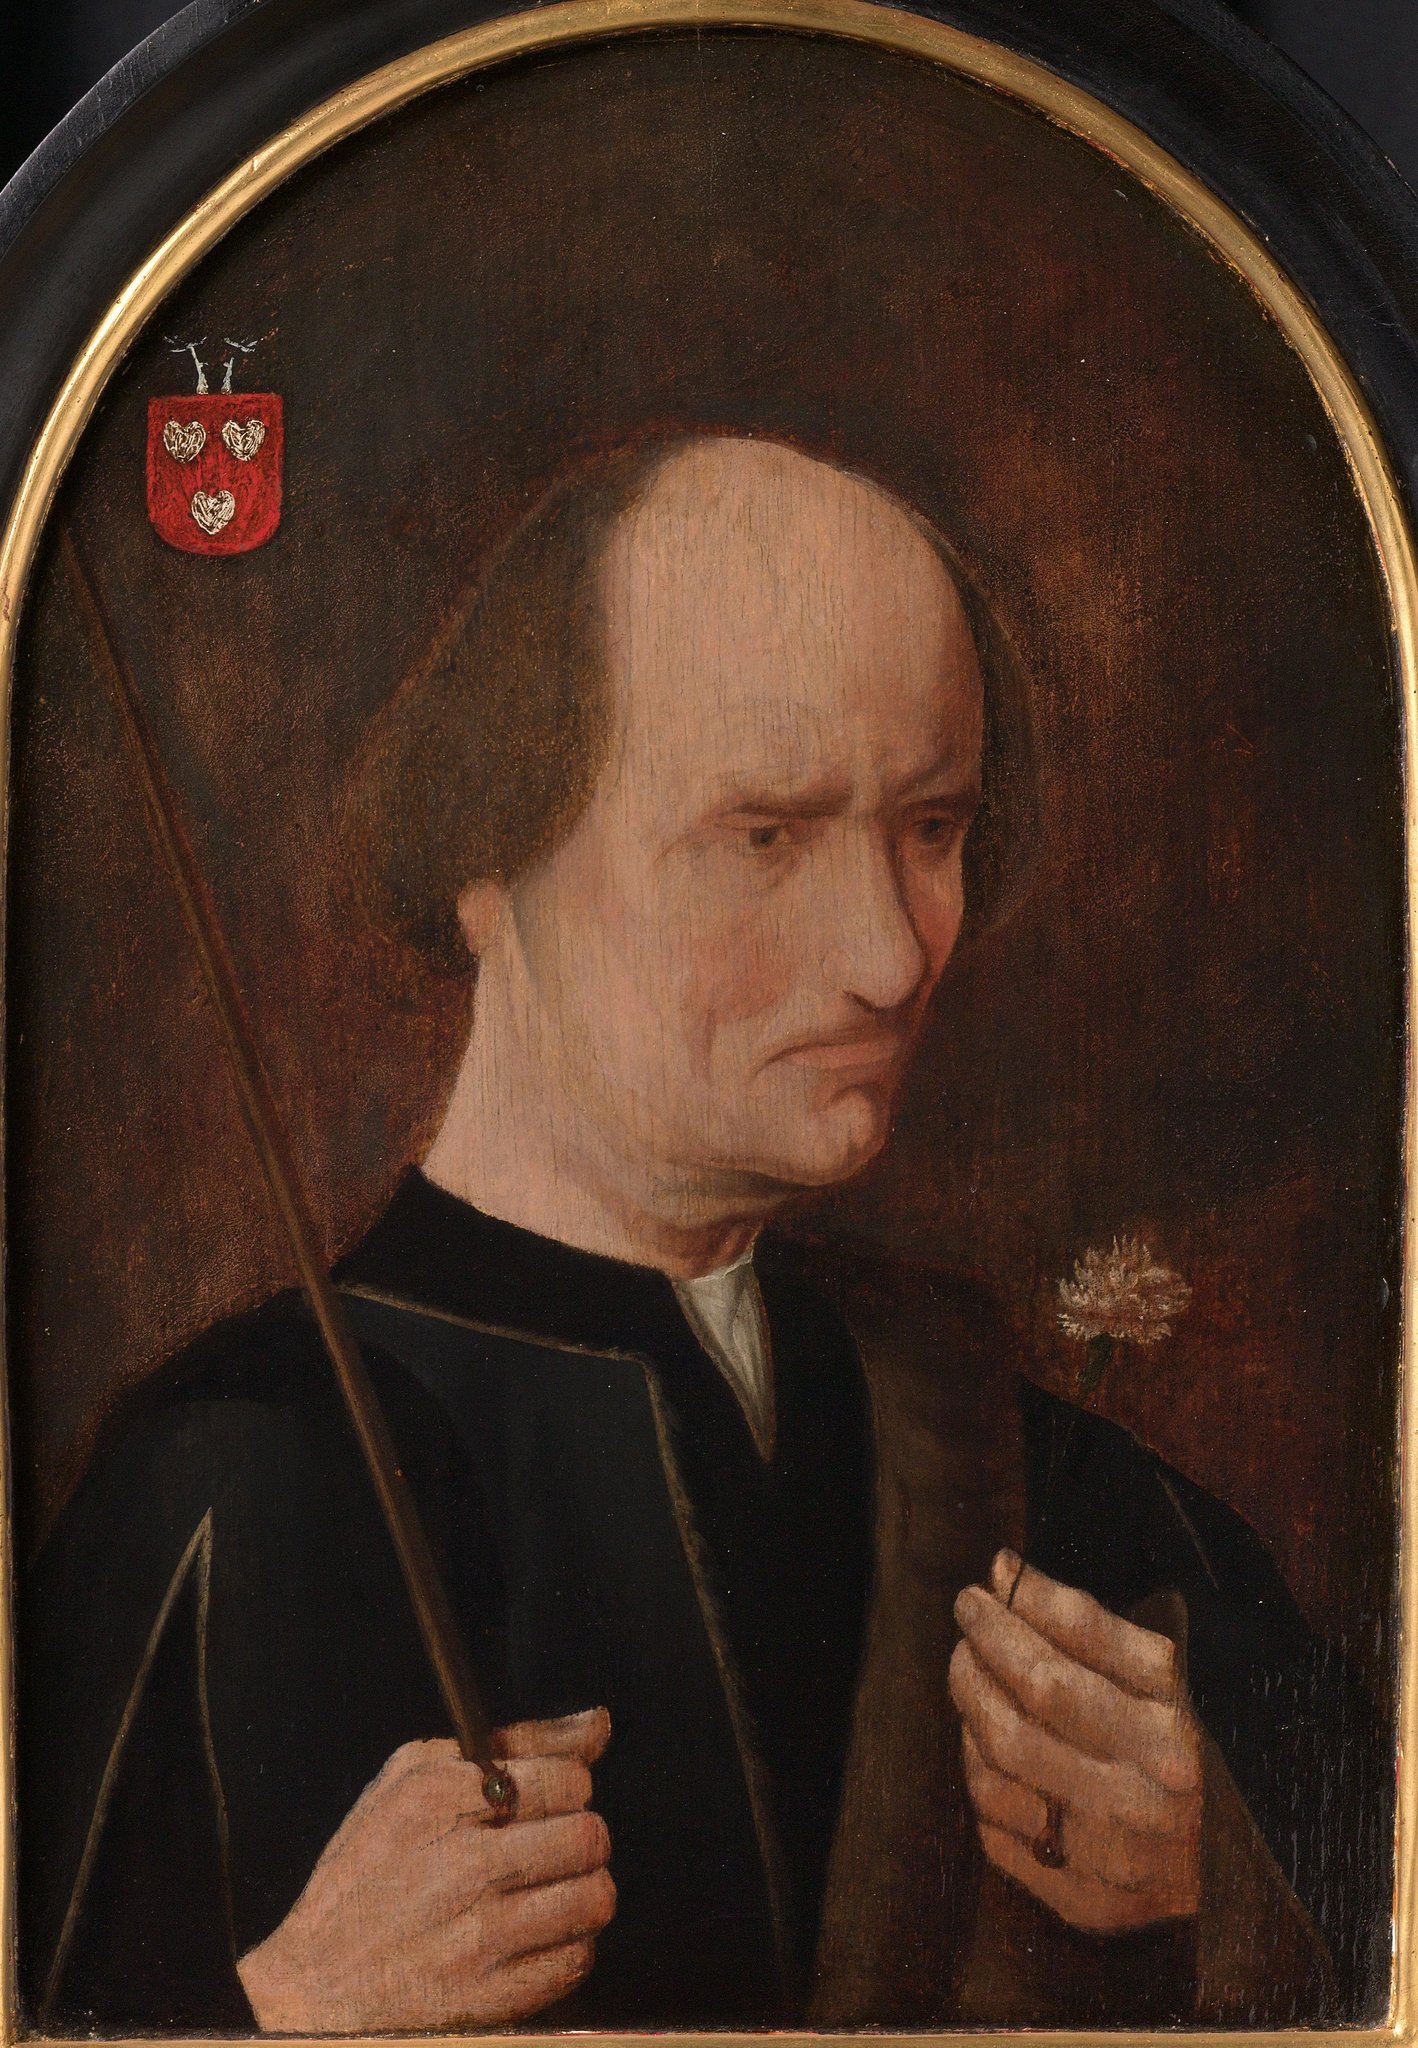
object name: painting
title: Portrait of Arent Franckensz van der Meer, Lord of Papendrecht, called Malicious Aertje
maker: Anonymous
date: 1550-1560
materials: oil, panel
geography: northern netherlands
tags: historical persons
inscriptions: coat of arms, upper left: three silver water lilies, two above one, on a red field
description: Portret van Arent Franckensz van der Meer (overl. 1503), heer van Pendrecht, dijkgraaf en baljuw van Delfland en de schout van Delft, bijgenaamd 'quaet Aertje'. Buste, een stok in de rechterhand en een anjer in de linkerhand. Linksboven het familiewapen. Met integrale lijst. Pendant van SK-A-4716.